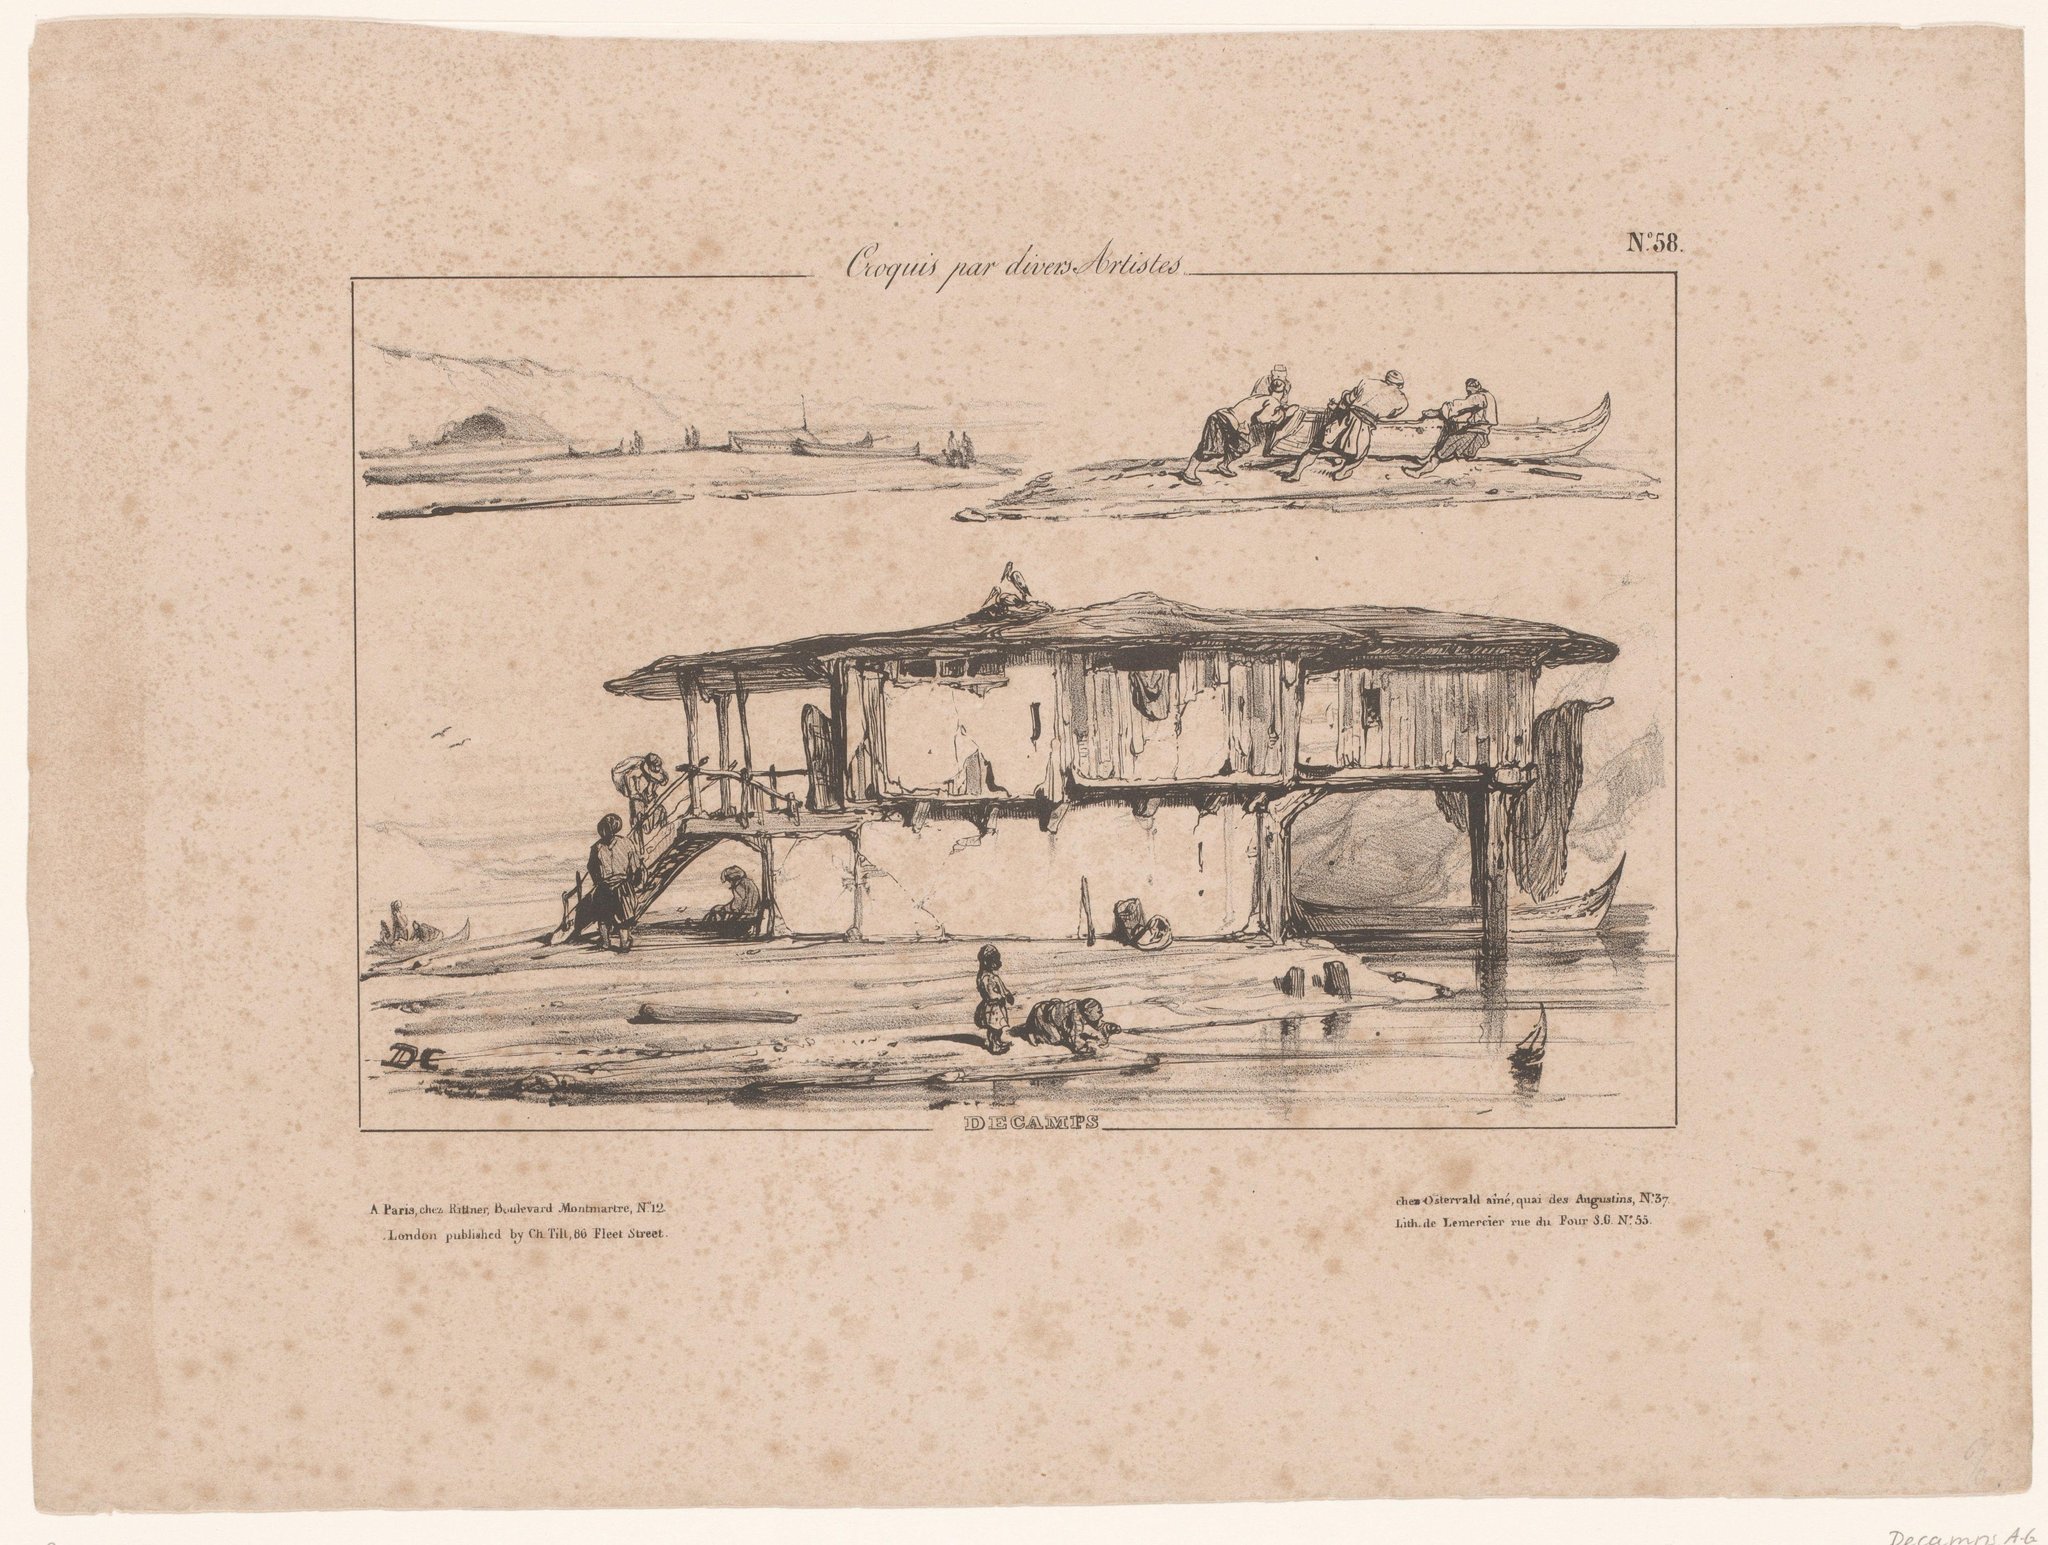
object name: print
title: Croquis par divers artistes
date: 1830-1831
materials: paper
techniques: lithograph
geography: paris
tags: commercial fishery, other dwelling types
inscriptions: collector's mark: Lugt 2228a